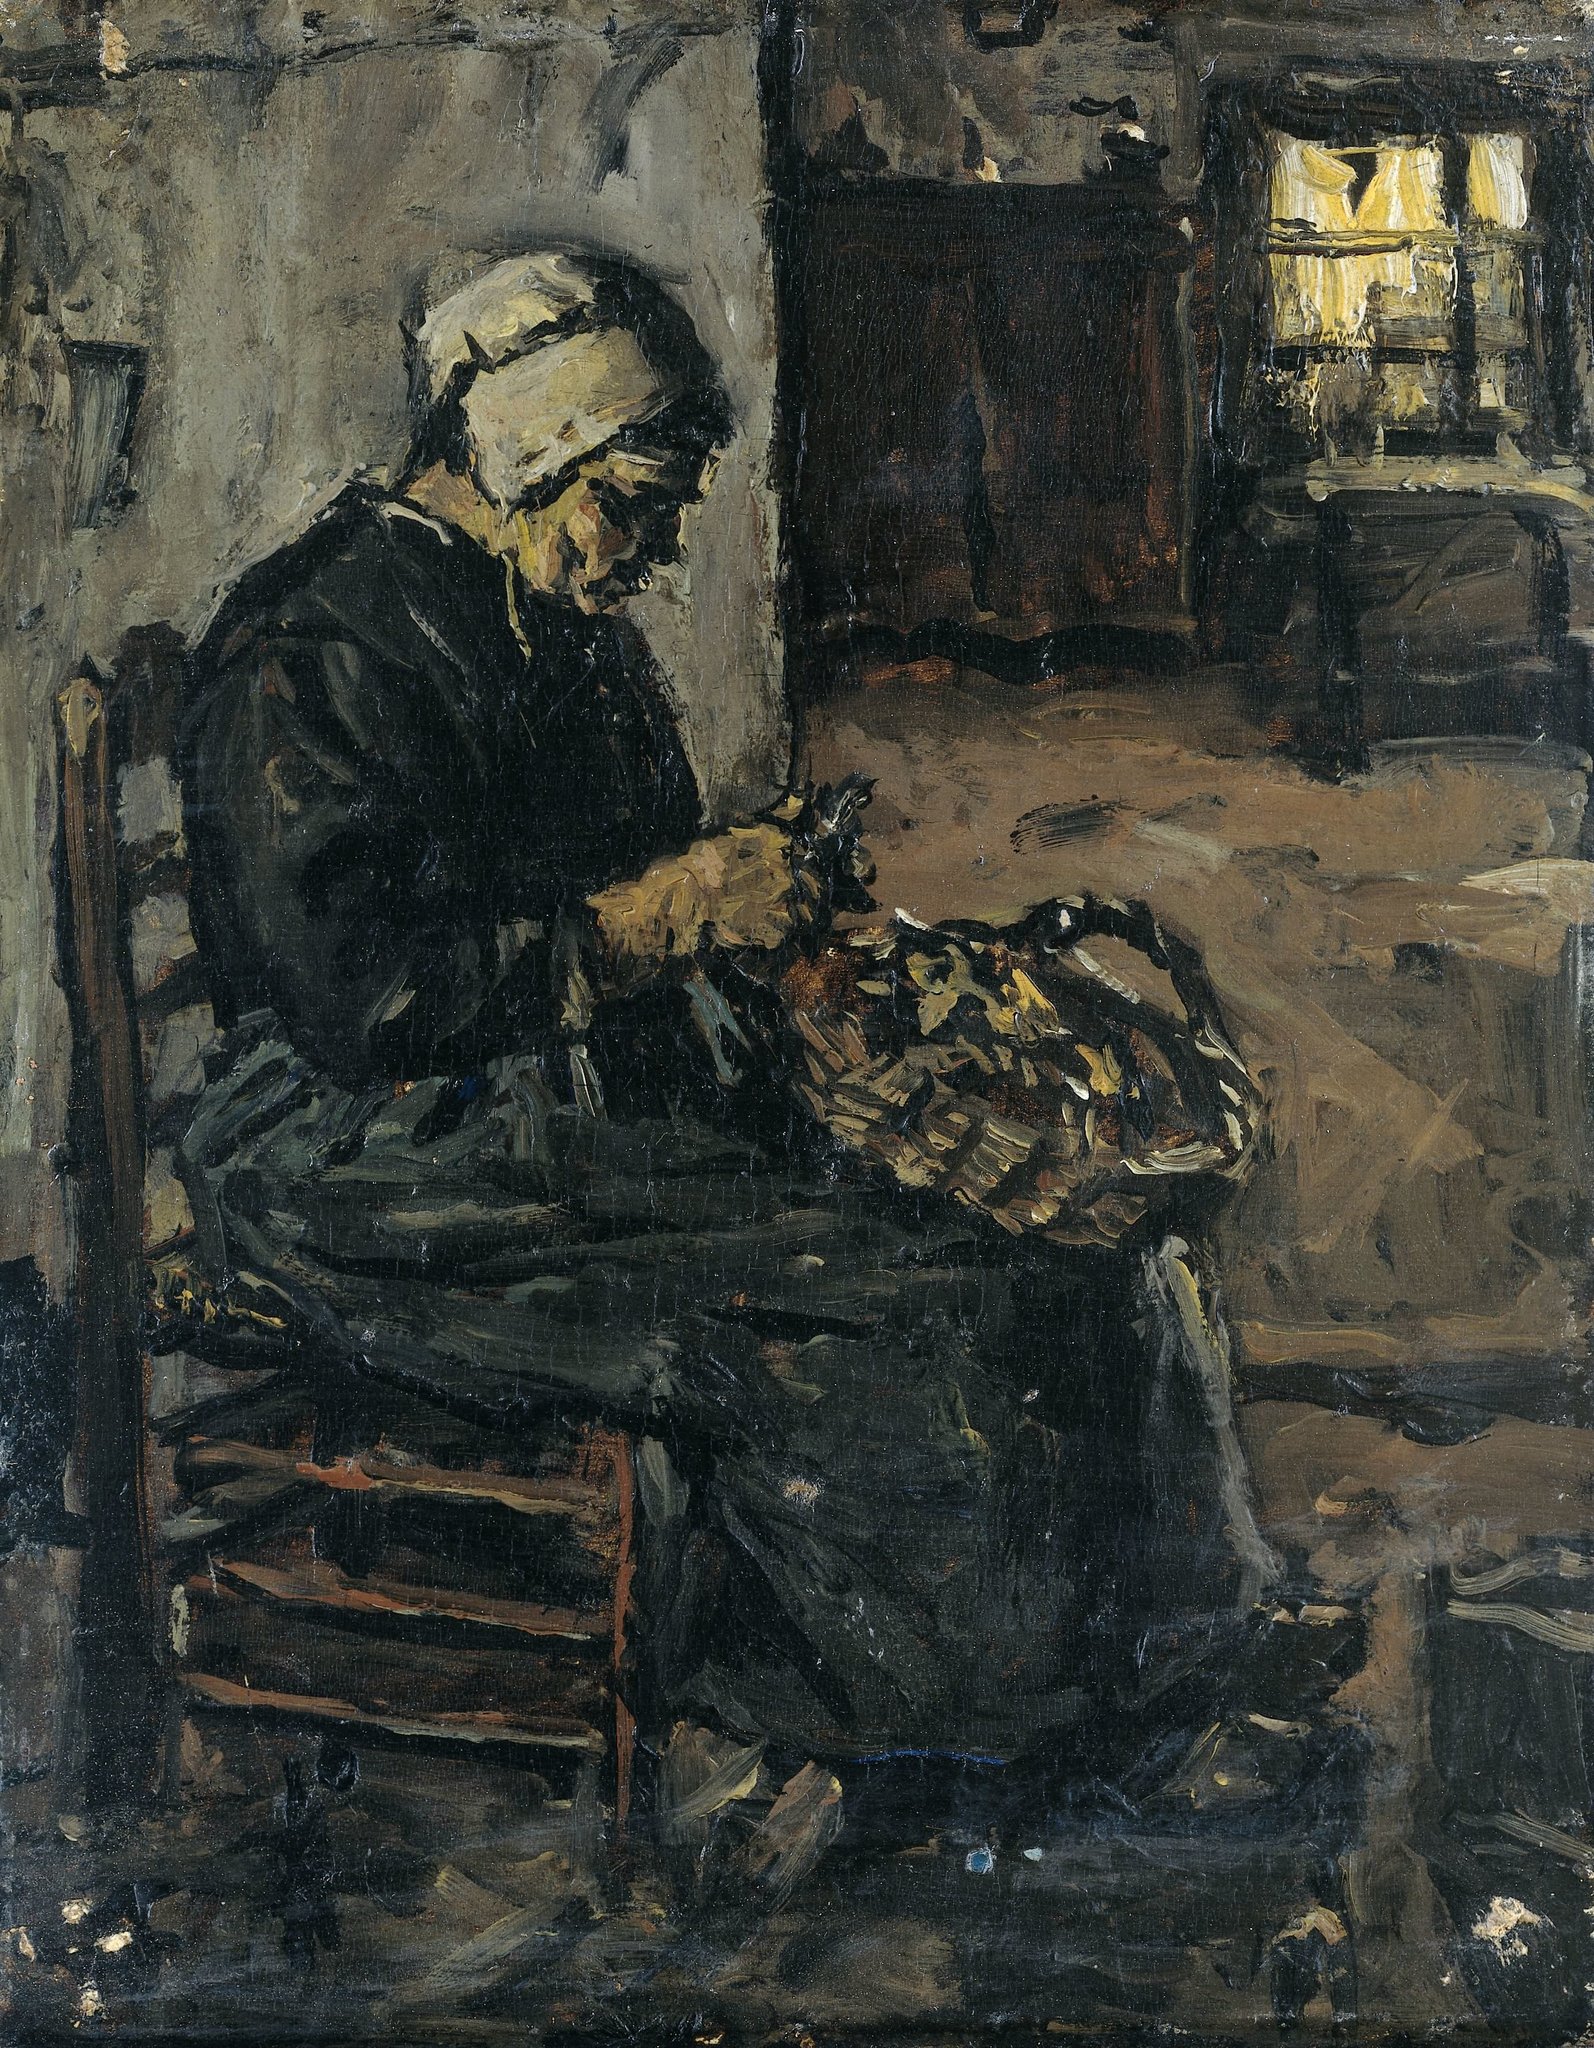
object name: painting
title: Peasant Woman Peeling Potatoes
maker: suze robertson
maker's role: draughtsman, painter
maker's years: 1855-1922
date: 1875-1922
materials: oil, panel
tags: potatoes, cleaning vegetables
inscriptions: workshop stamp: ‘Atelier Suze Robertson’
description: Interieur met een boerenvrouw die zittend in een stoel aardappels aan het schillen is. Rechts een doorkijk naar een andere kamer.